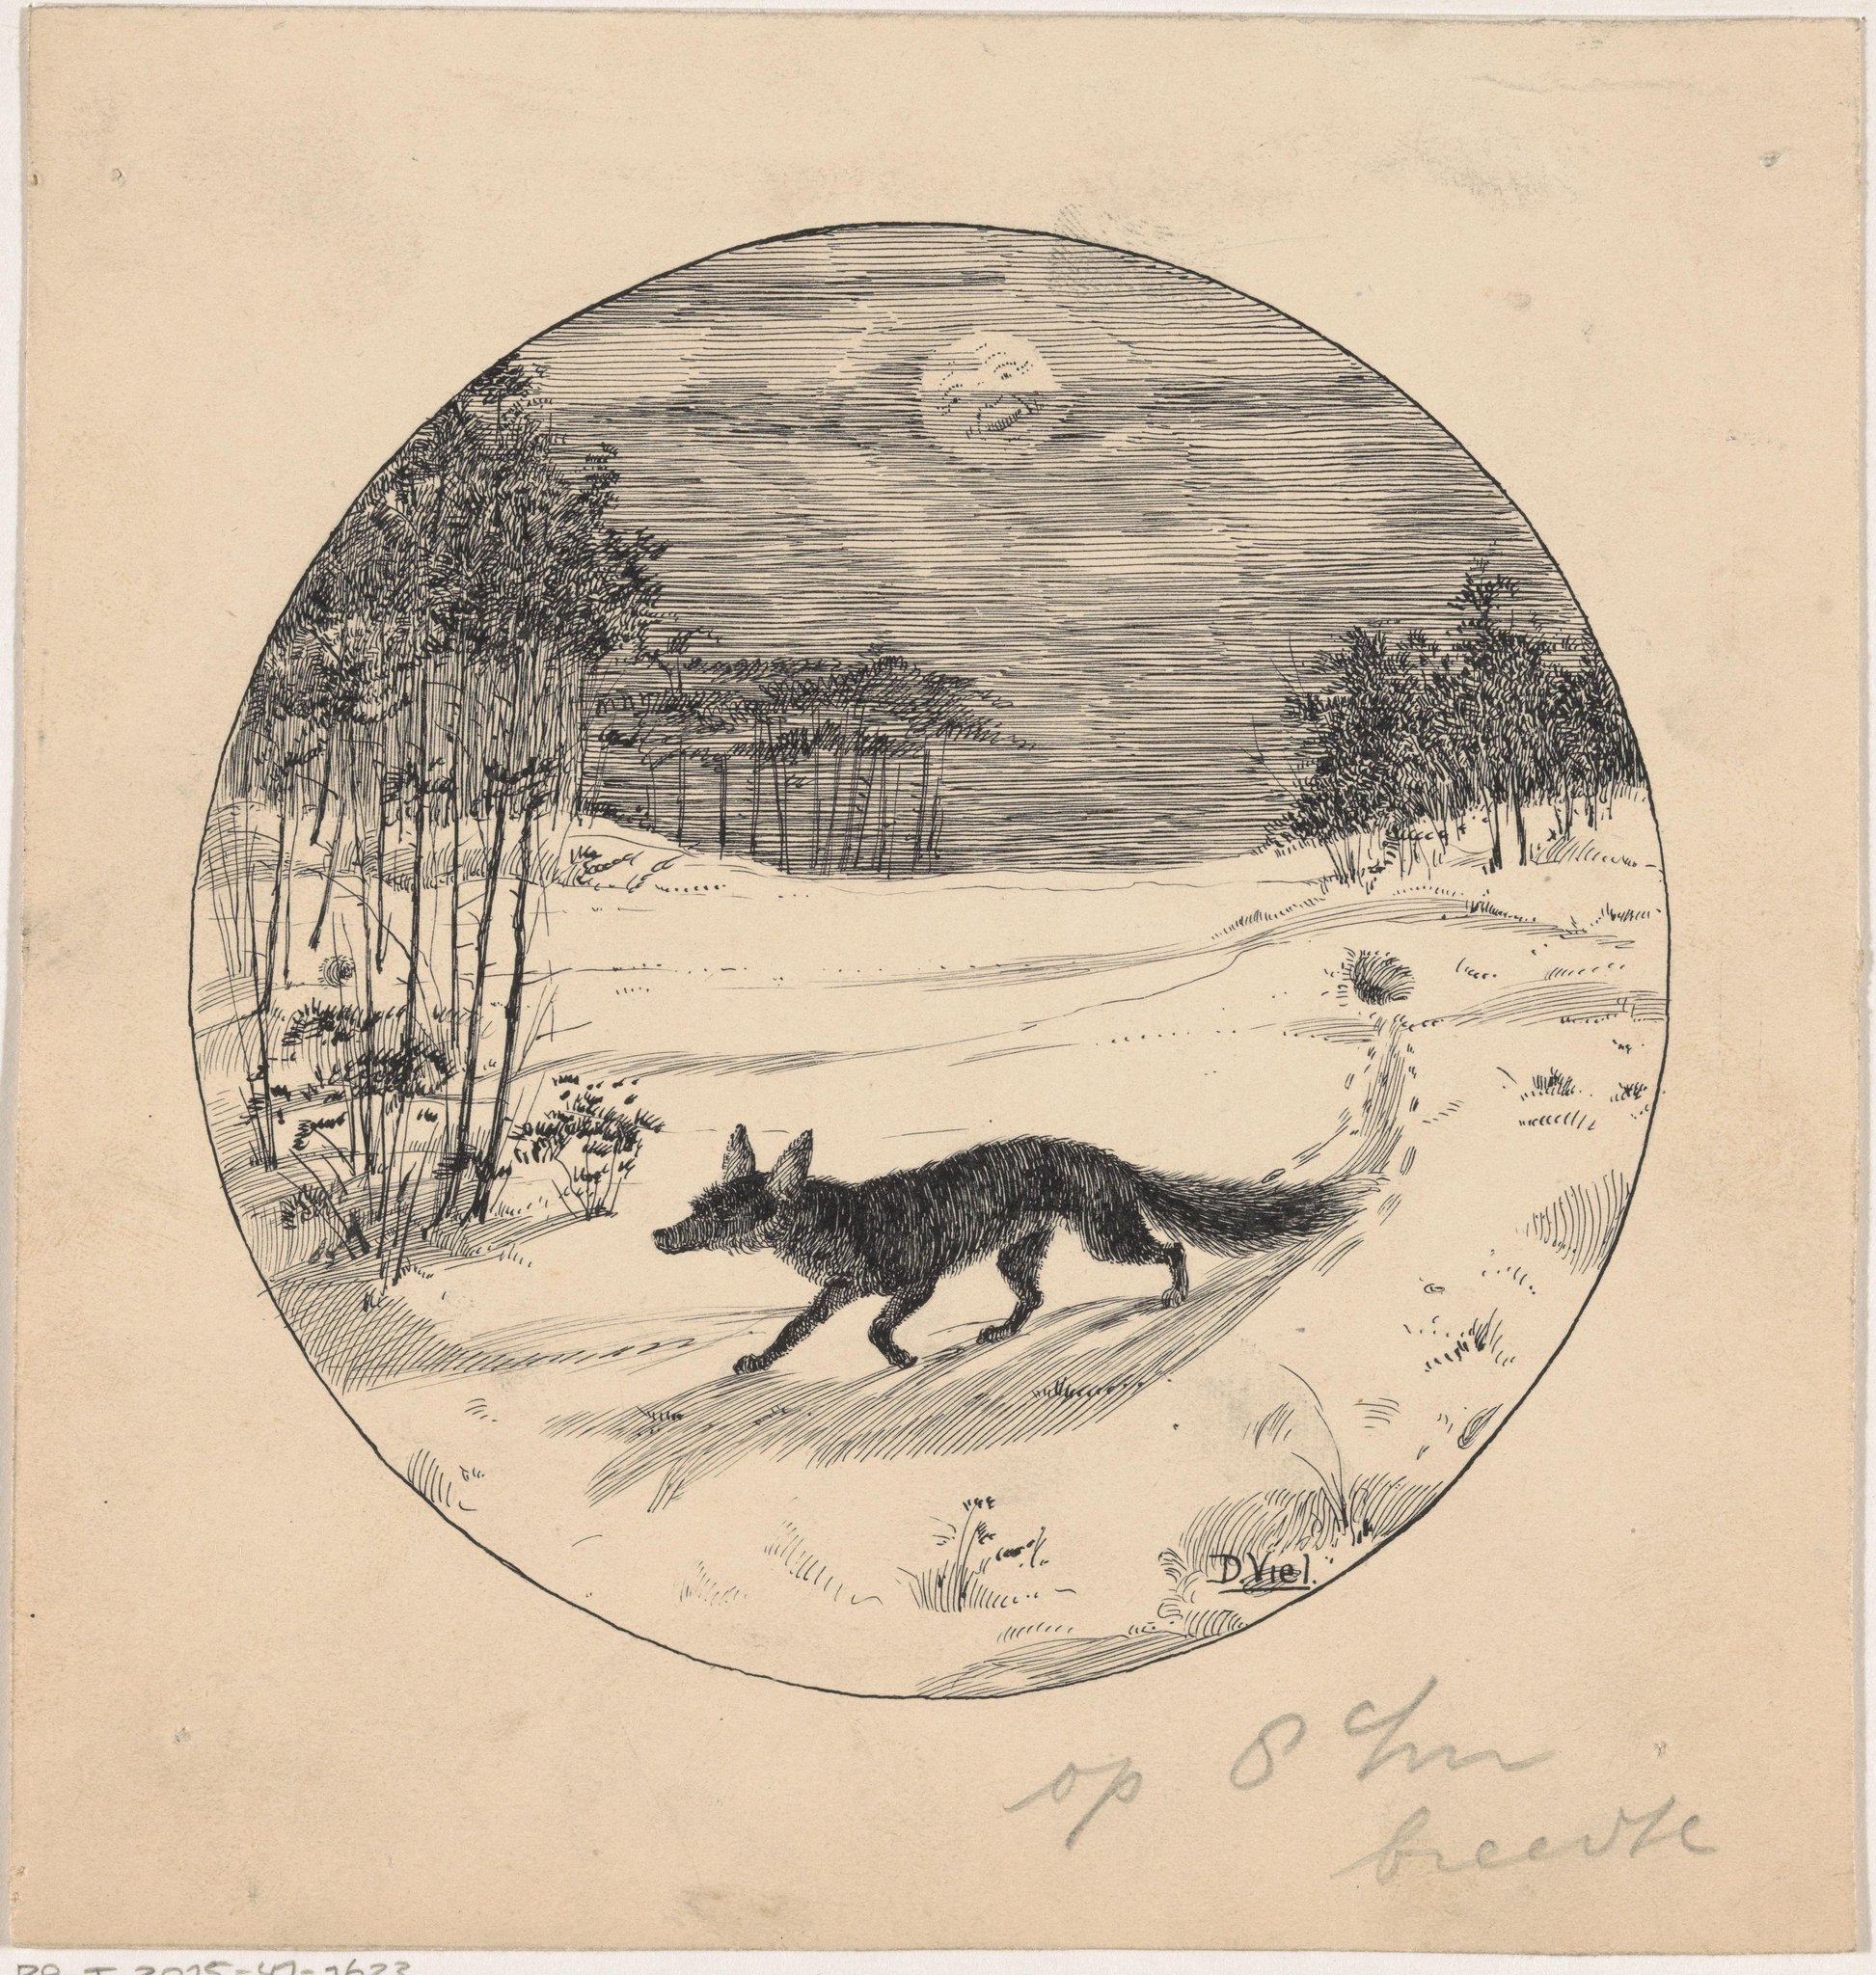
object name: drawing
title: Rood-Reintje de vos sluipt over de hei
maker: d. viel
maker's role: draughtsman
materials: ink, paper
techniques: pen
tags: night, beasts of prey, predatory animals: fox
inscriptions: collector's mark: Lugt 2228, signature: ‘D. Viel’, :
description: Ontwerp voor: Dietz, Henriette e.a. De witte muizen: vertellingen voor jongens en meisjes. Ons thuis-serie. Amsterdam: Veen, 1924.